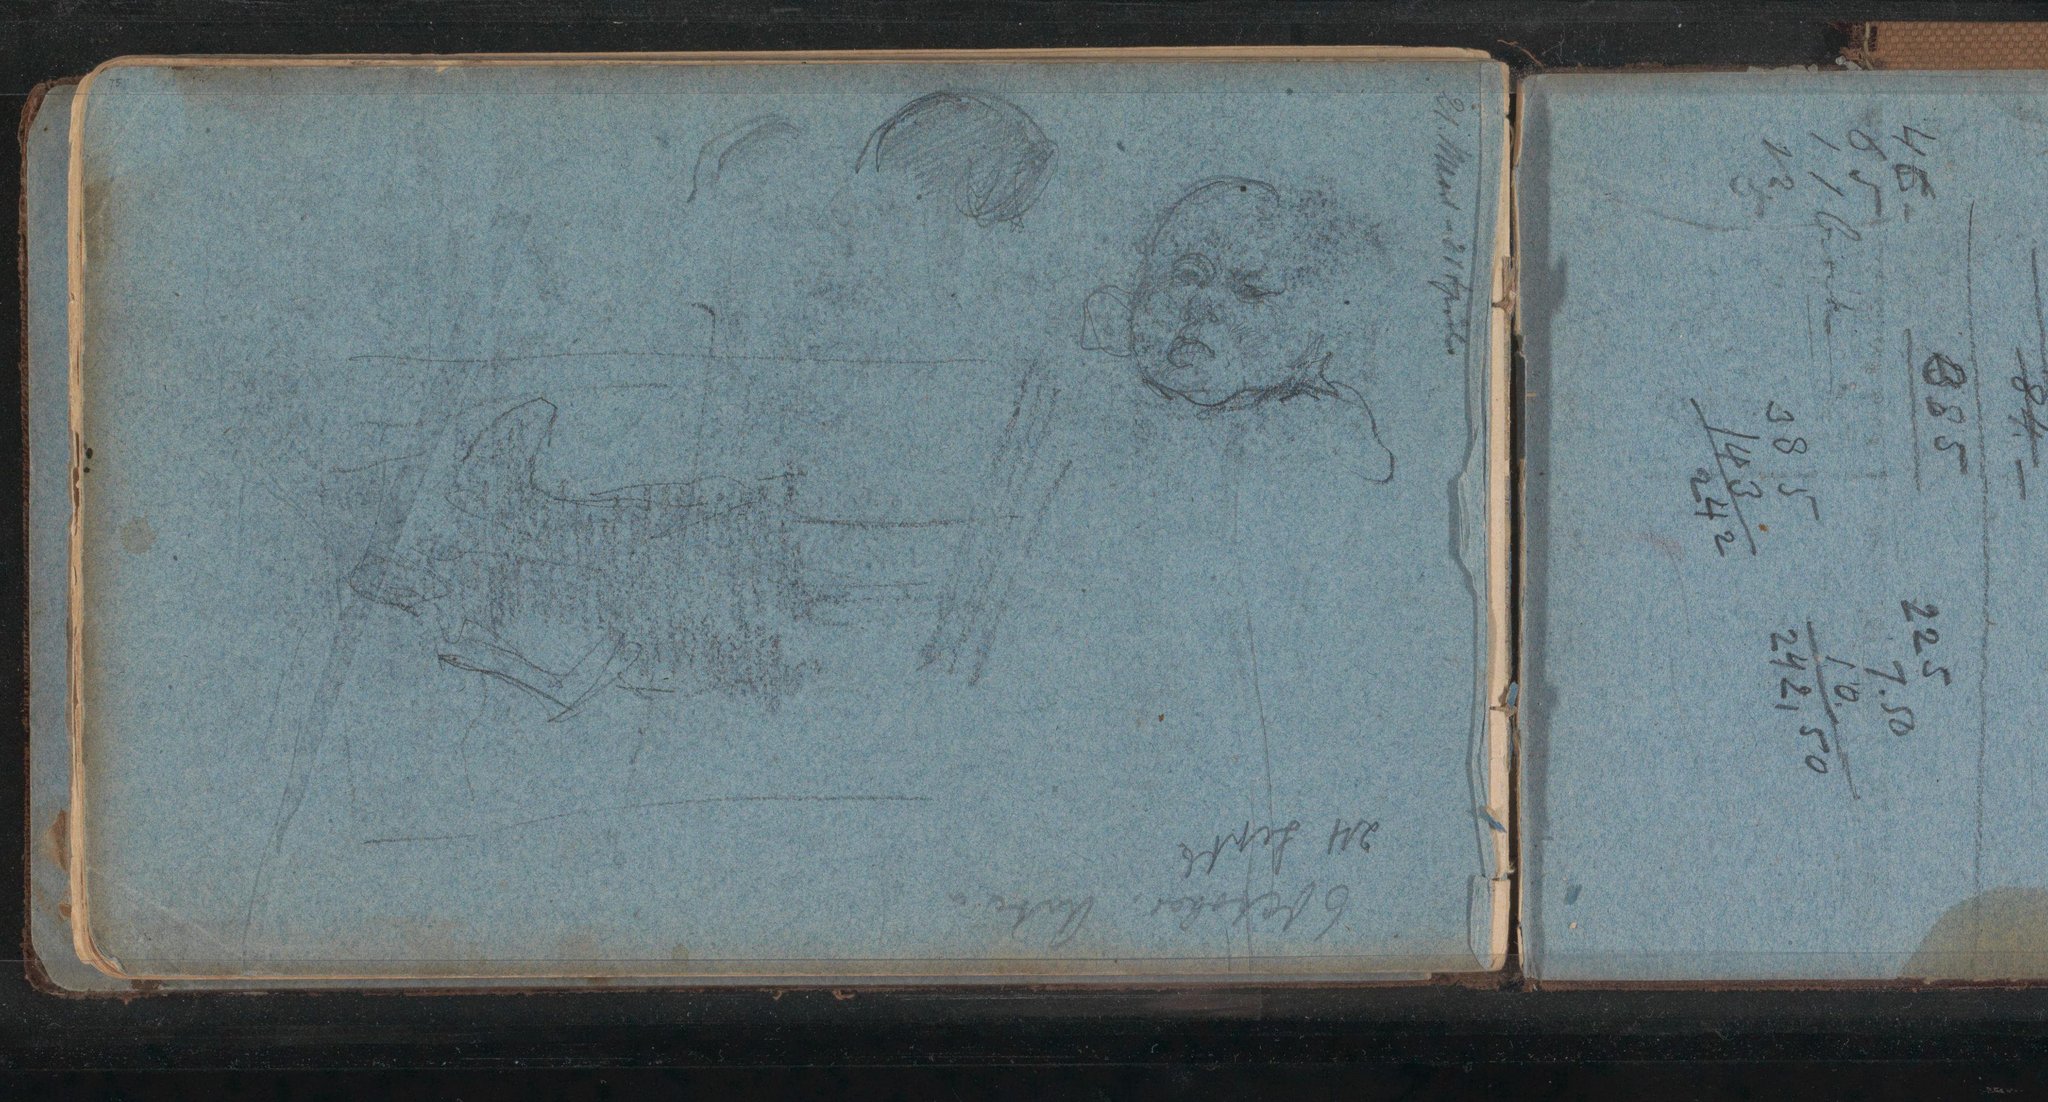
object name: endleaf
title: Ruiter en een kinderhoofd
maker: george hendrik breitner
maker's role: draughtsman, painter, print maker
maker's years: 1857-1923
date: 1880-1882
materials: chalk, paper, pencil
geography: scheveningen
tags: riding a horse, ass, or mule; rider, horseman, child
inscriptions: date: ‘21 maart-27 april/ 6 October Arti/ 24 Sept.’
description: Pagina 75, vrij schutblad, uit een schetsboek met 37 bladen.